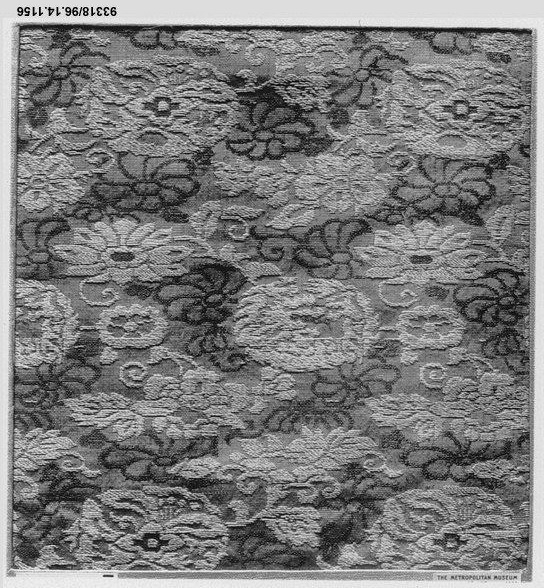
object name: piece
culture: japanese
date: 1701-1900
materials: silk